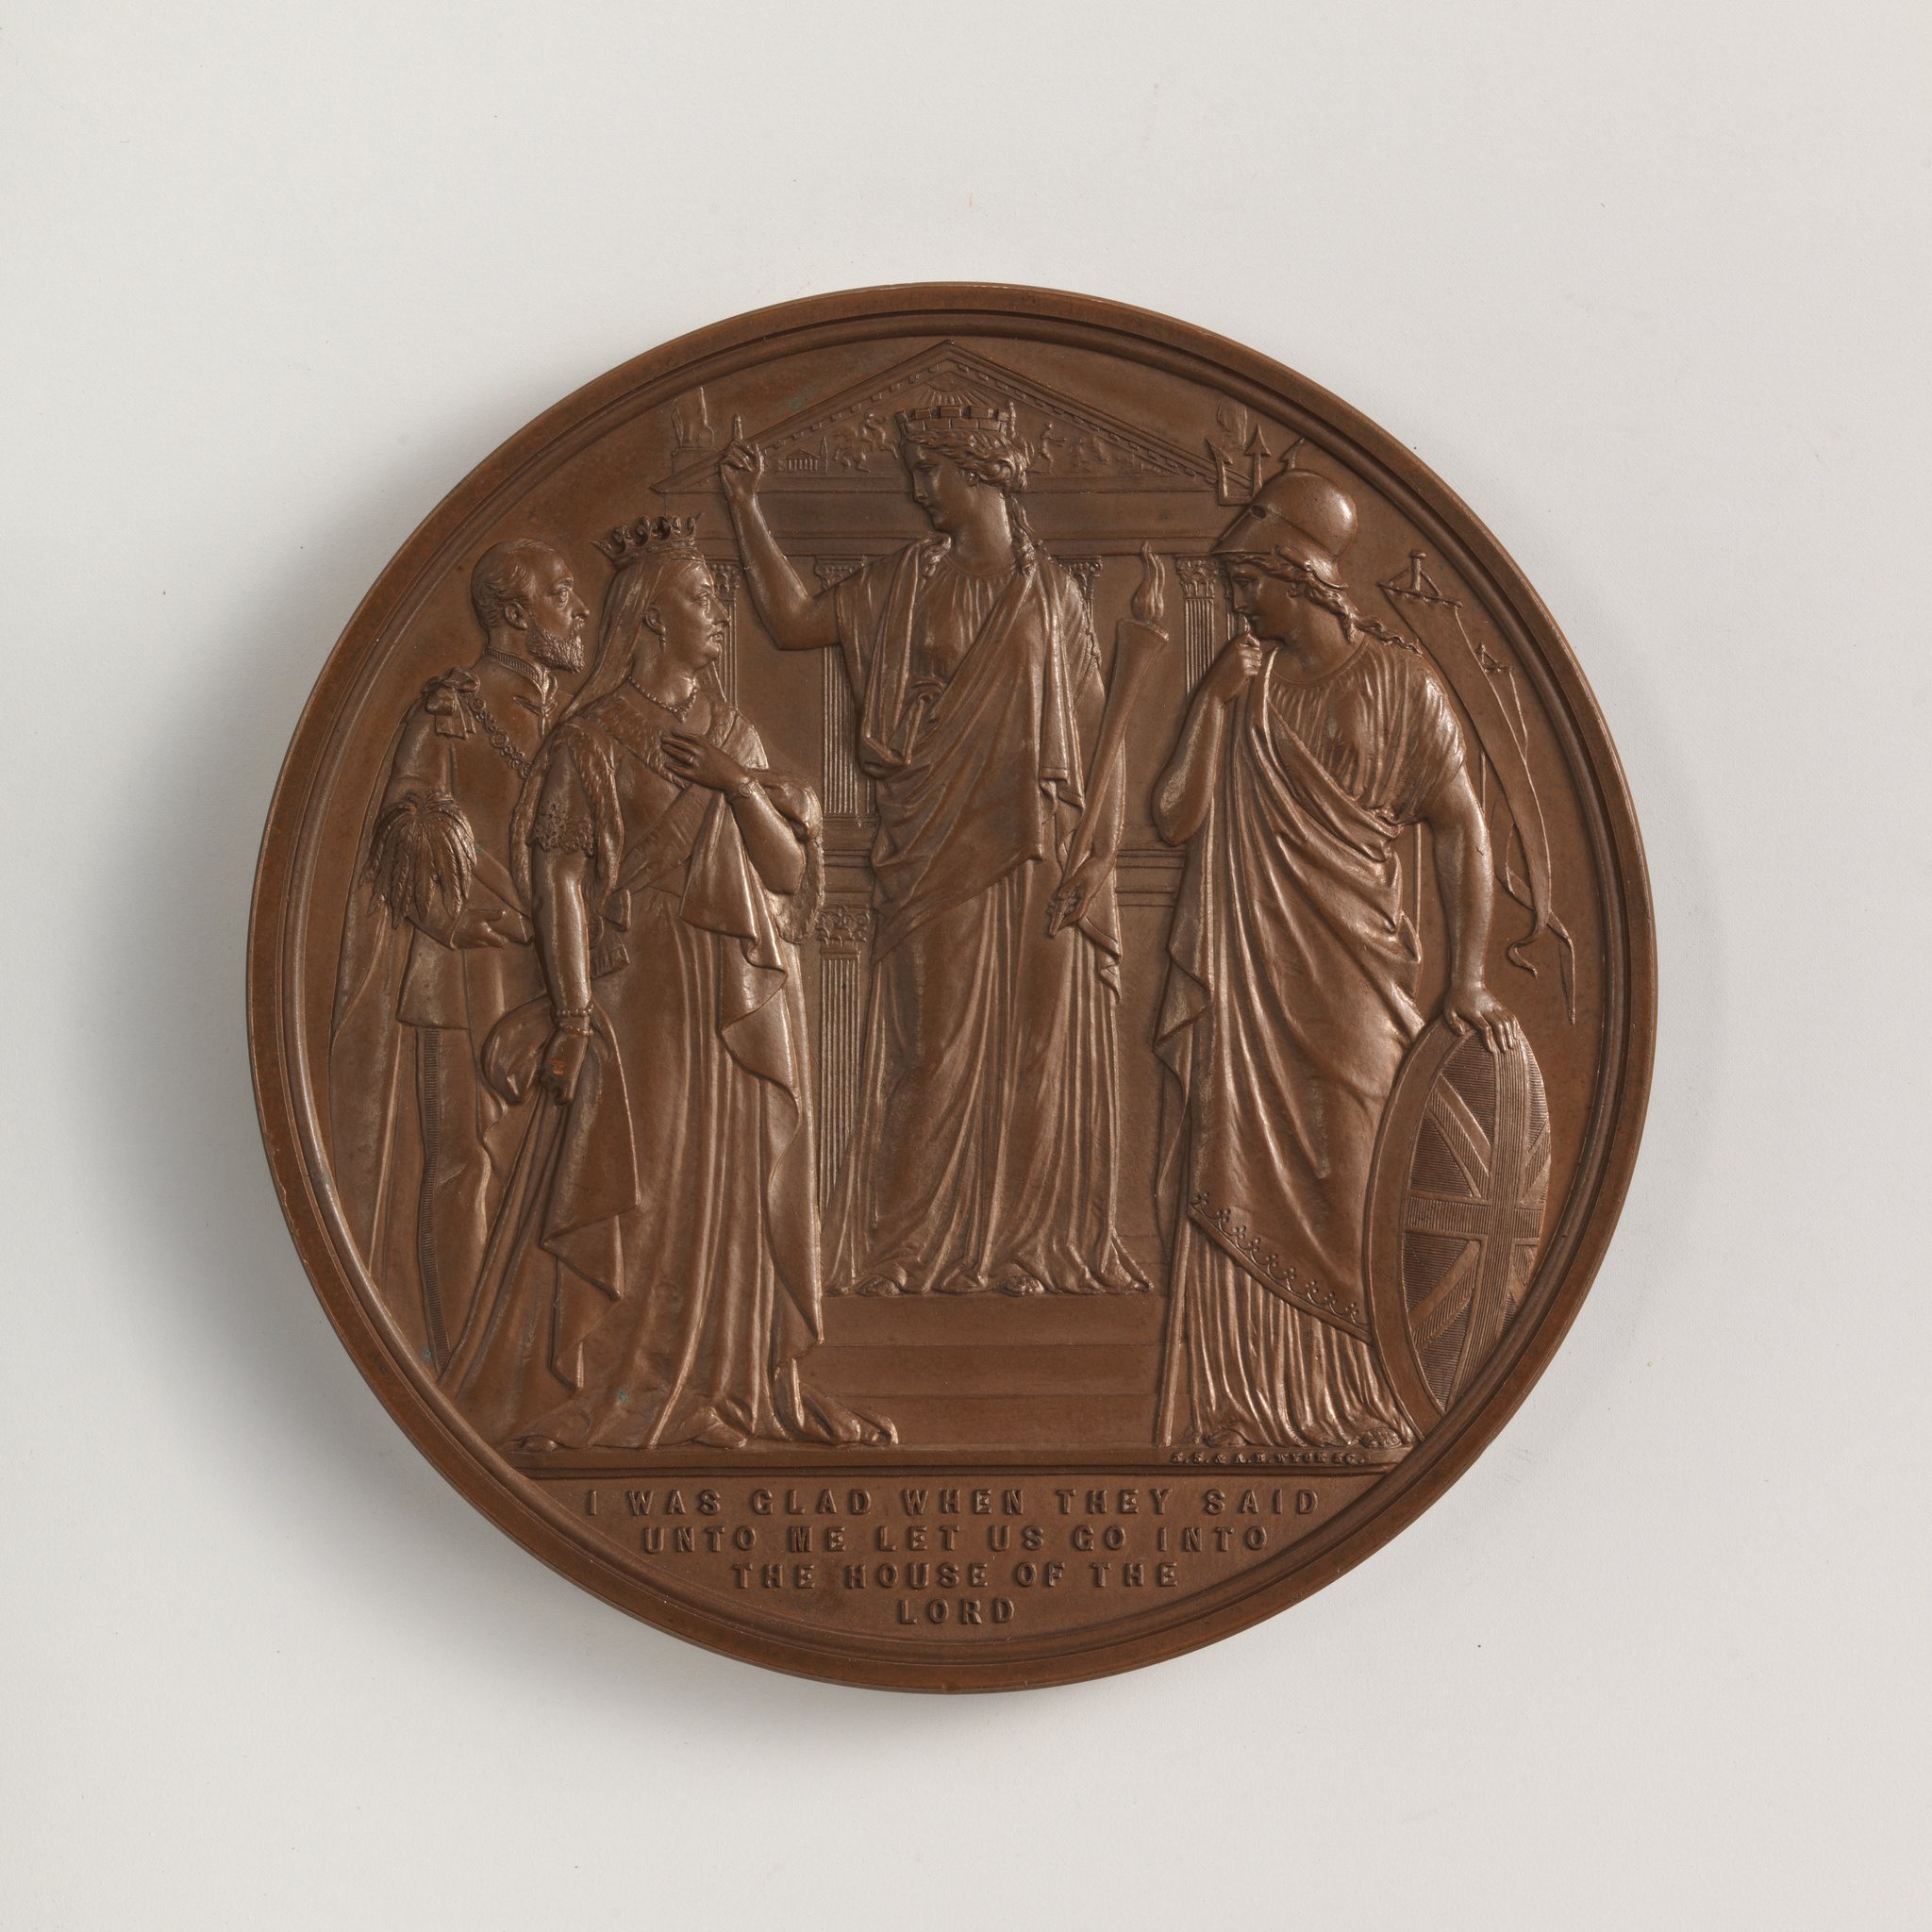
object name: medal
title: Service of Thanksgiving for Recovery of Prince of Wales medal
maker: joseph shepherd wyon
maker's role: artist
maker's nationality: british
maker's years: 1836-1873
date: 1872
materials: bronze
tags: men,women,queen victoria